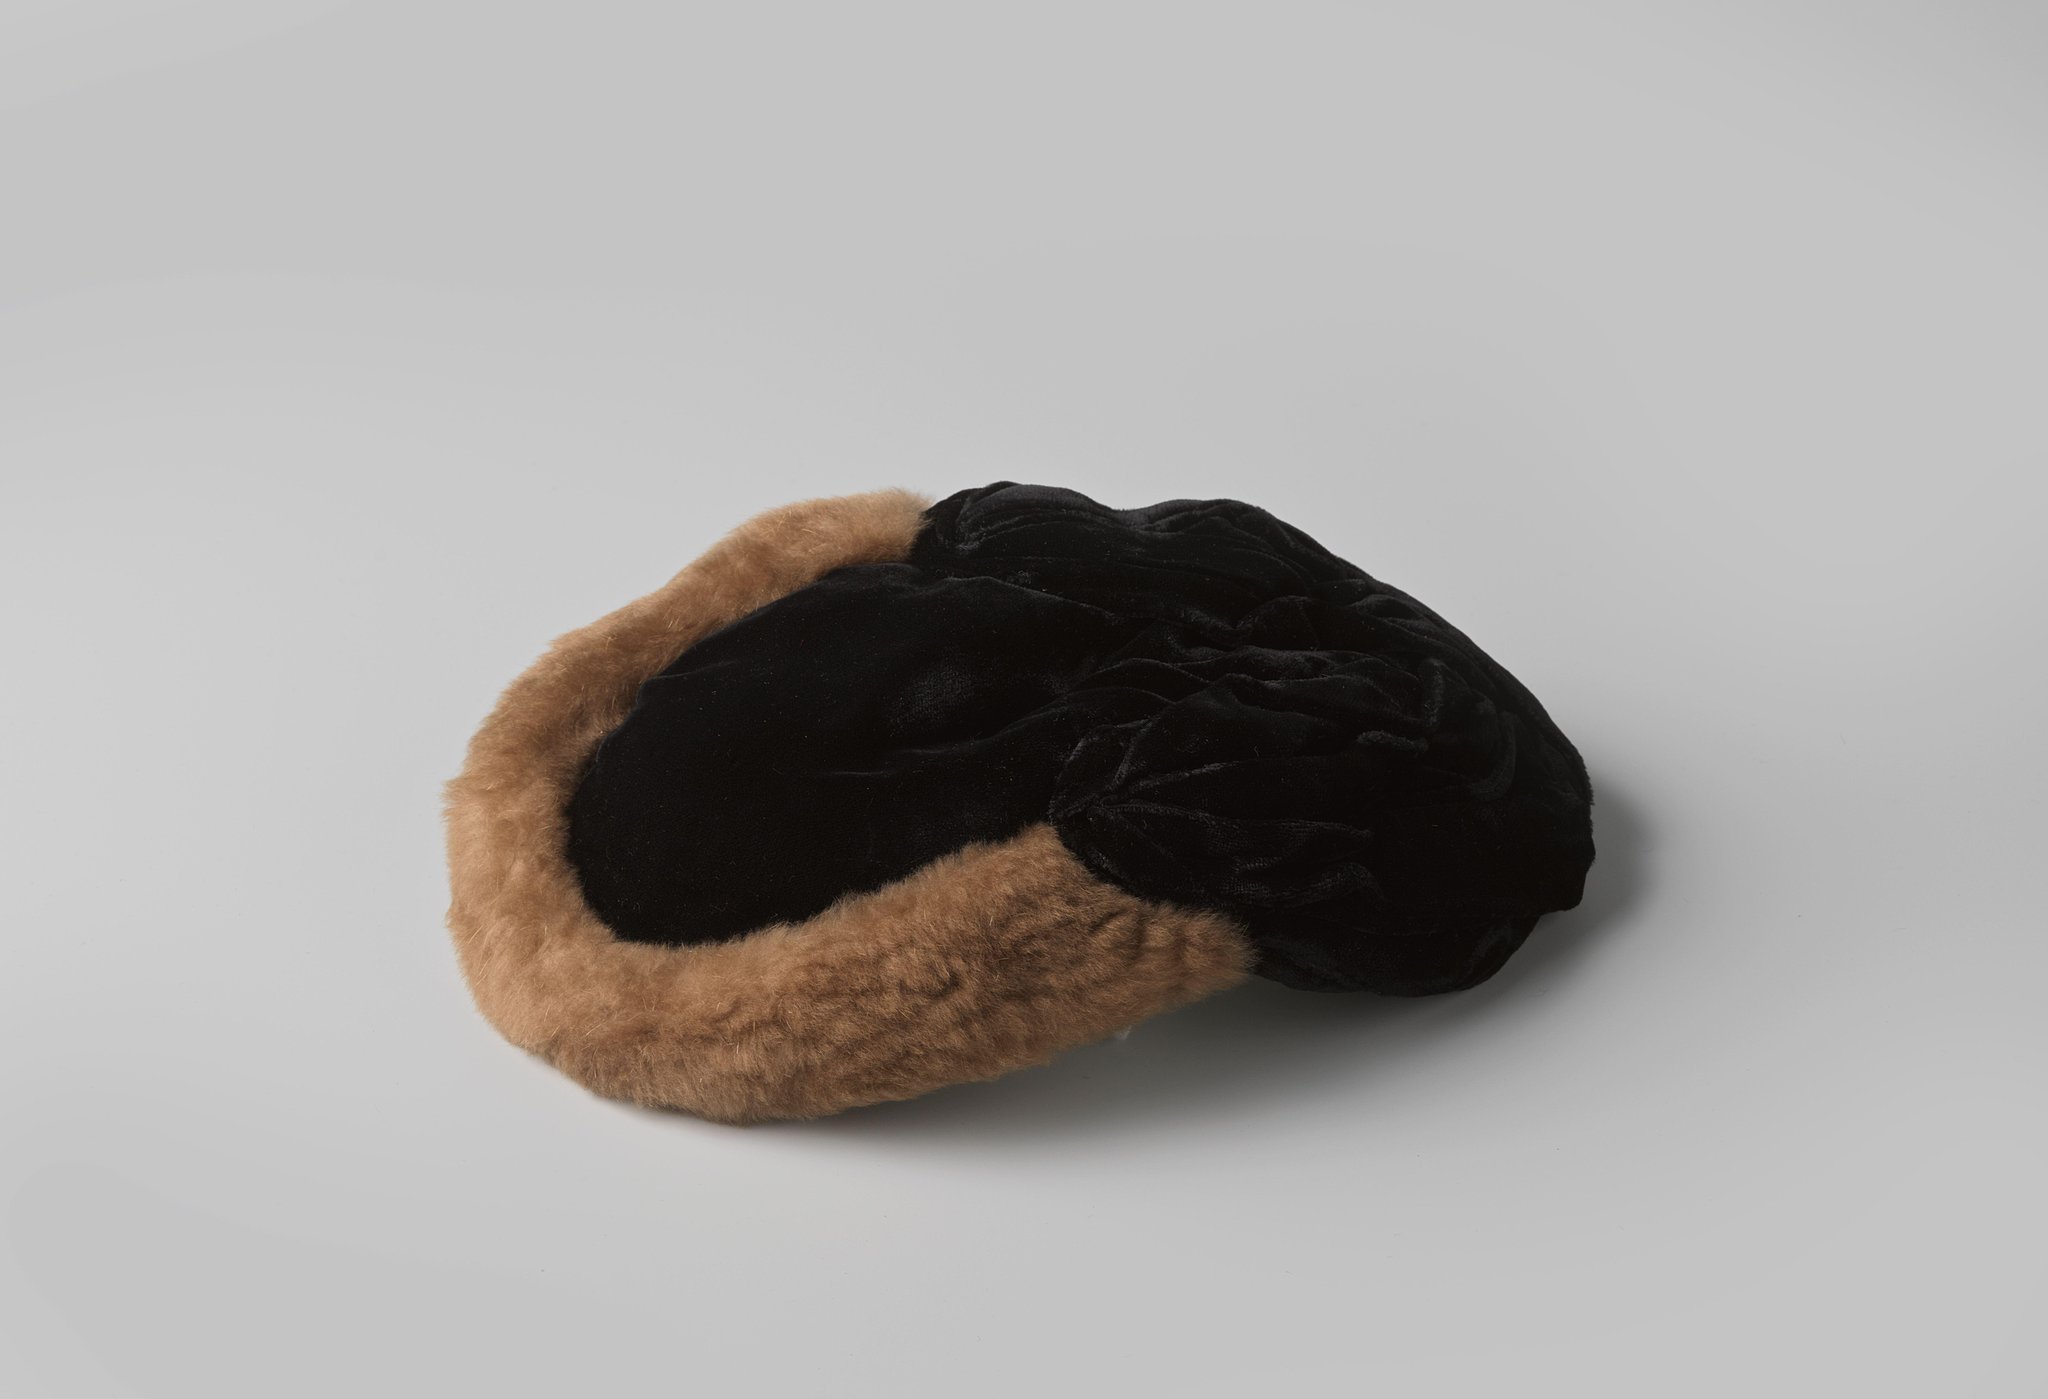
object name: womenswear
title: Hoed van zwart fluweel chiffon en lichtbruin bont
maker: Anonymous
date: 1935-1938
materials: textile, fur, metal, velvet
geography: amsterdam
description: Hoed van zwart fluweel chiffon en lichtbruin bont. Laag, op een in een achtvorm gelegde laiton. De voorste lob vlak liggend, de achterste lob, driehoekig van vorm, neerhangend en met twee gedrapeerde fluweelstroken verbreed. De capeline is van grof zwart stro, bedekt met tule. De voorste lob is met aan smalle rand bever- of bison(?)-bont afgezet.